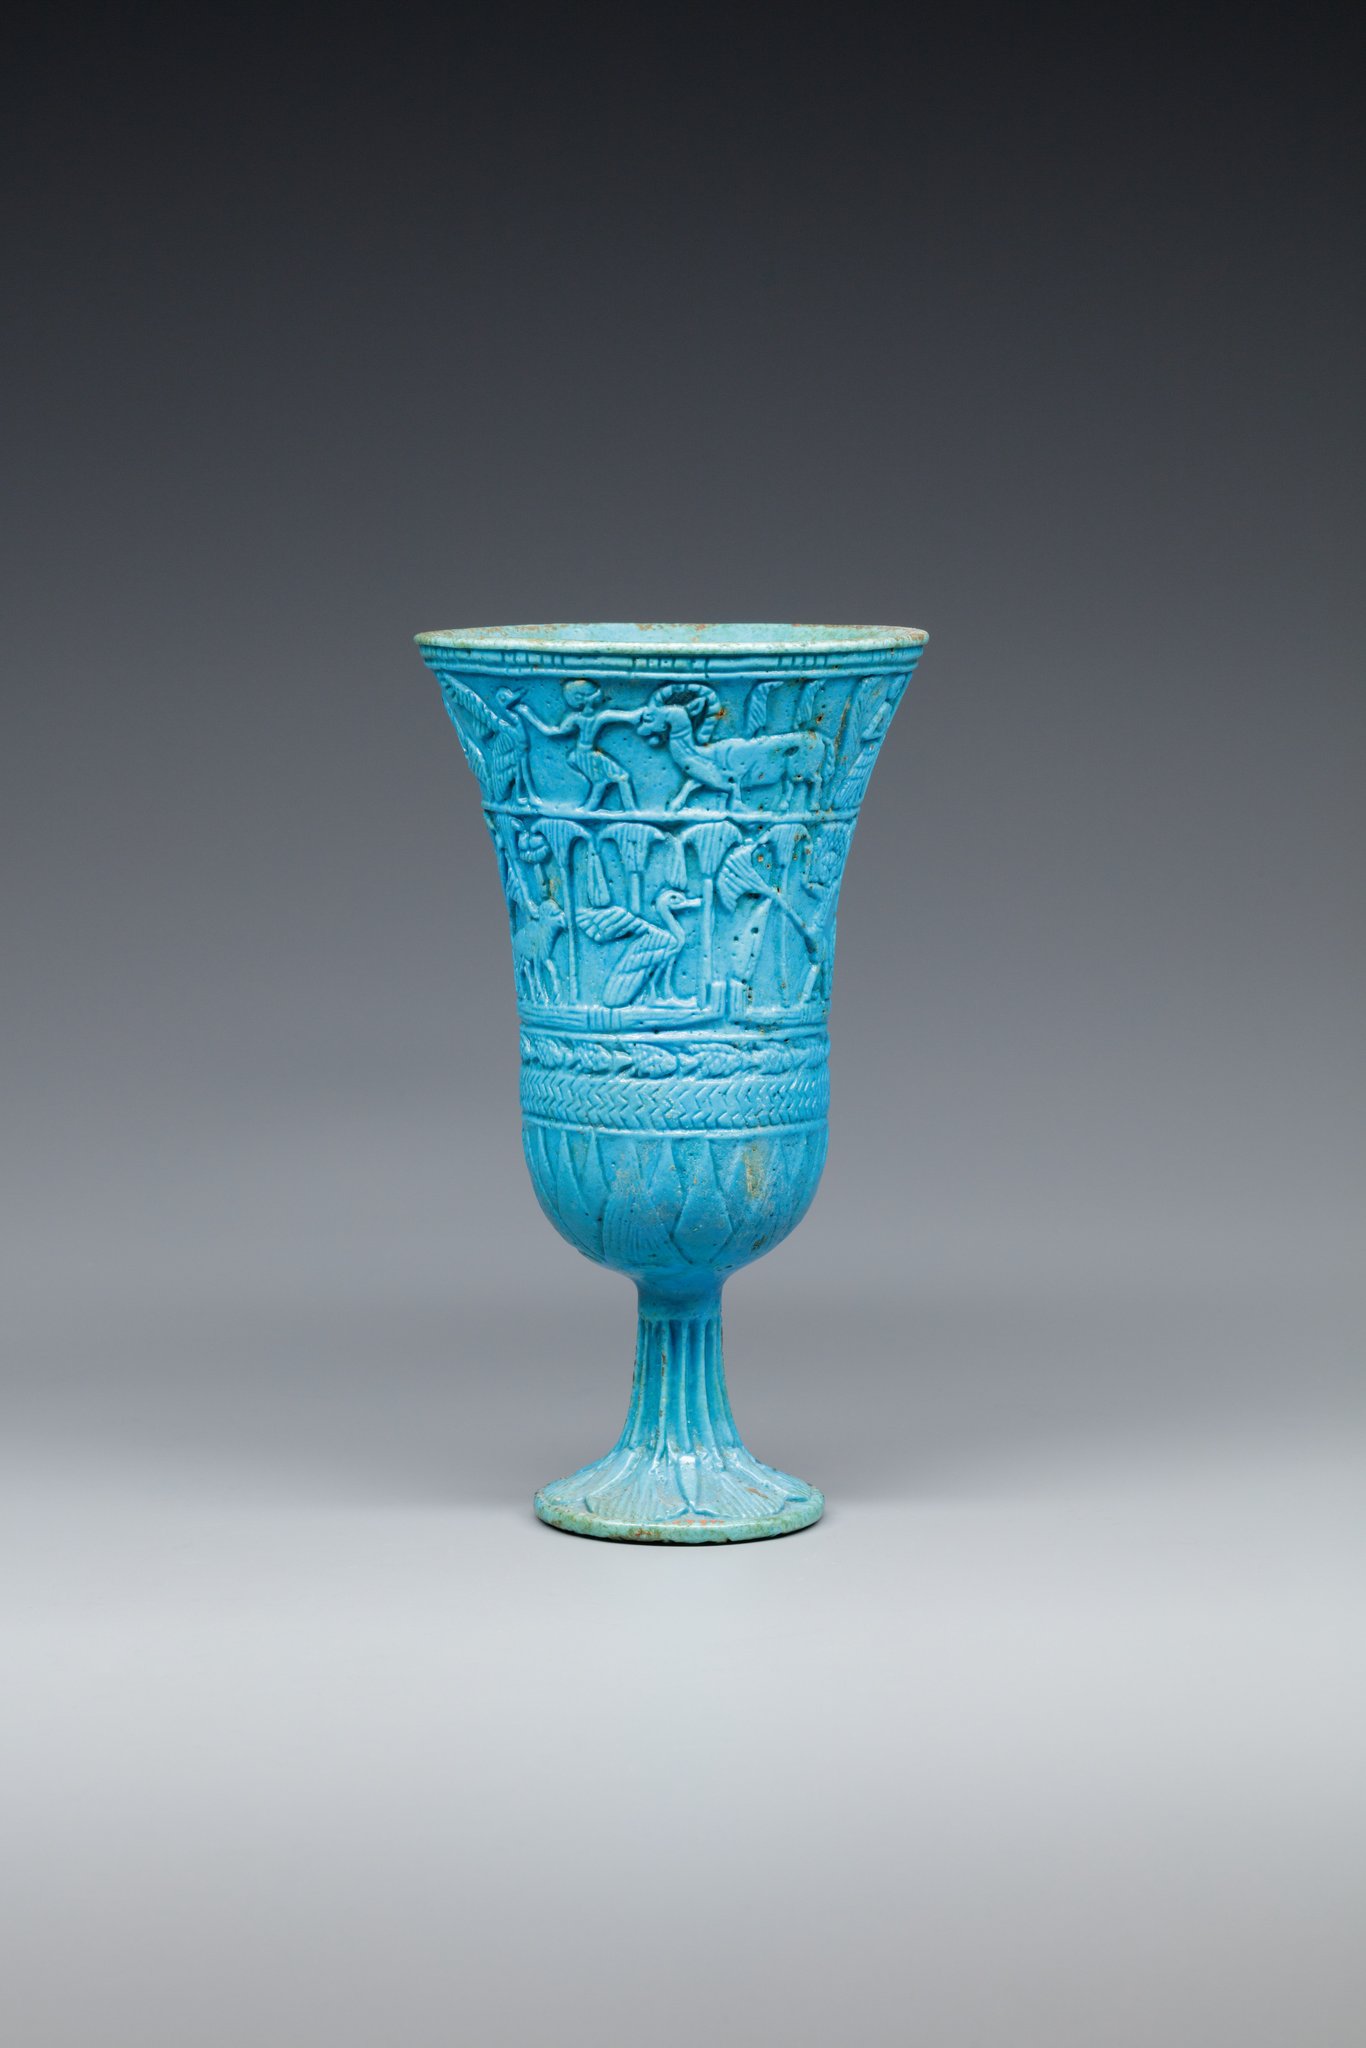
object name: chalice, cup, lotiform, relief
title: Lotiform Chalice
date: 945-664 BCE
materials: faience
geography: middle egypt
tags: birds,men,bulls,fish,lotuses